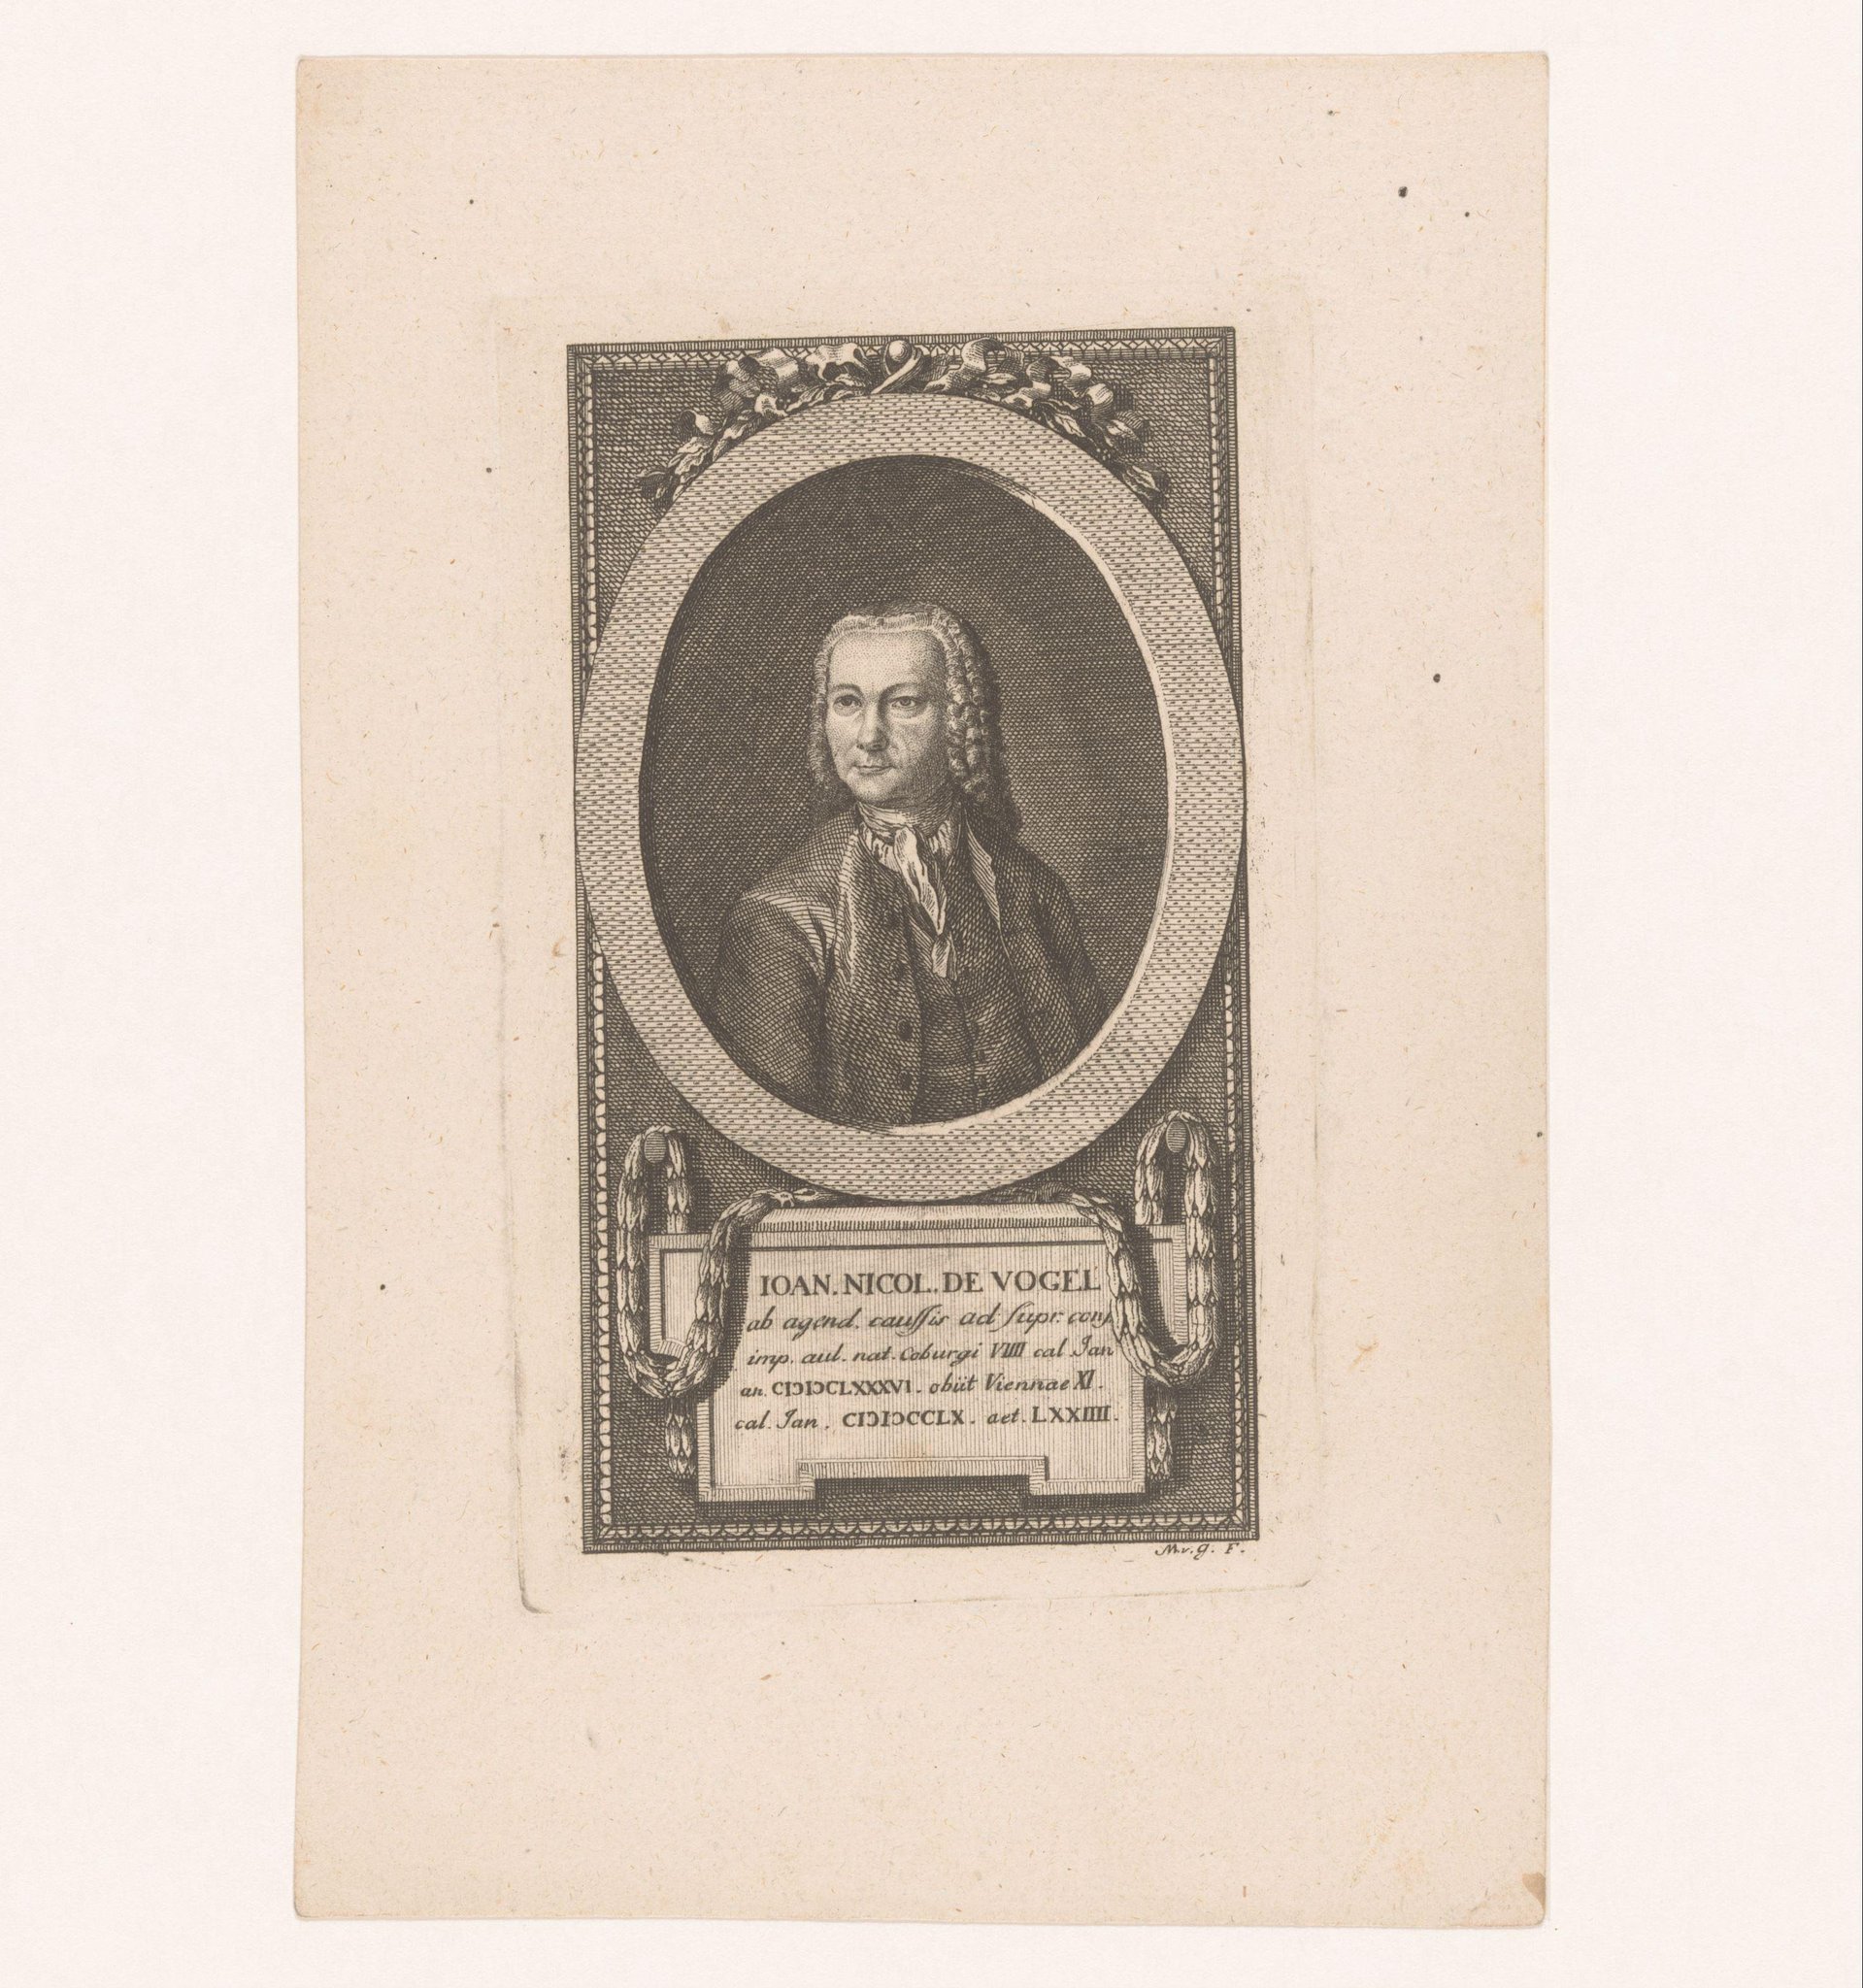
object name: print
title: Portret van Johann Nicolaus von Vogel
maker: monogrammist mvg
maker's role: print maker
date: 1770-1799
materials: paper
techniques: etching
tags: vienna, historical persons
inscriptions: collector's mark: Lugt 2228